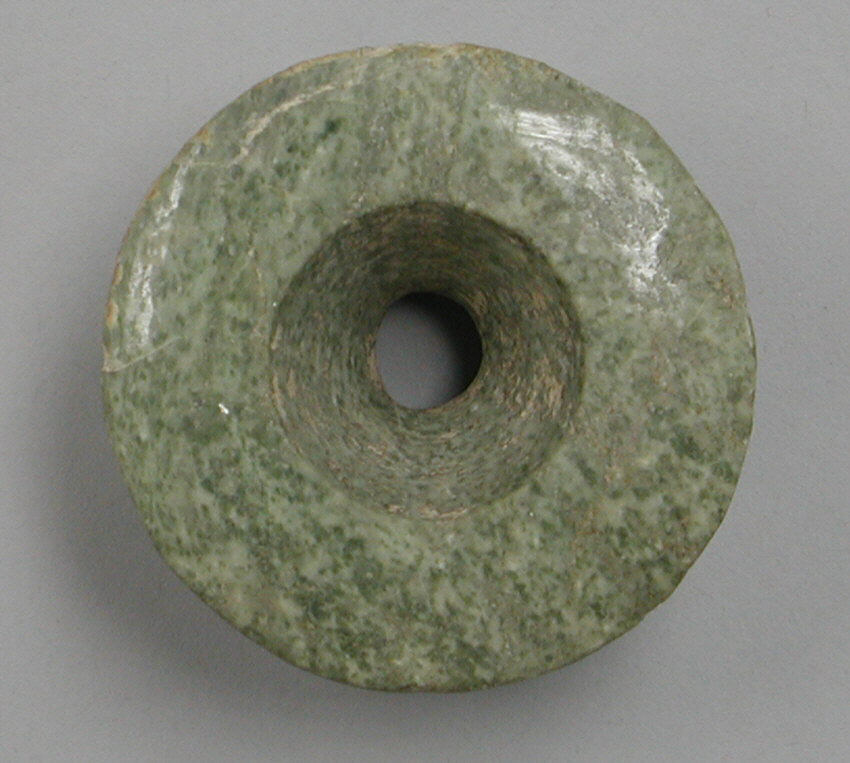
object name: earflare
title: Stone Earflare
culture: mexican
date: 1501-1600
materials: stone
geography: mexico